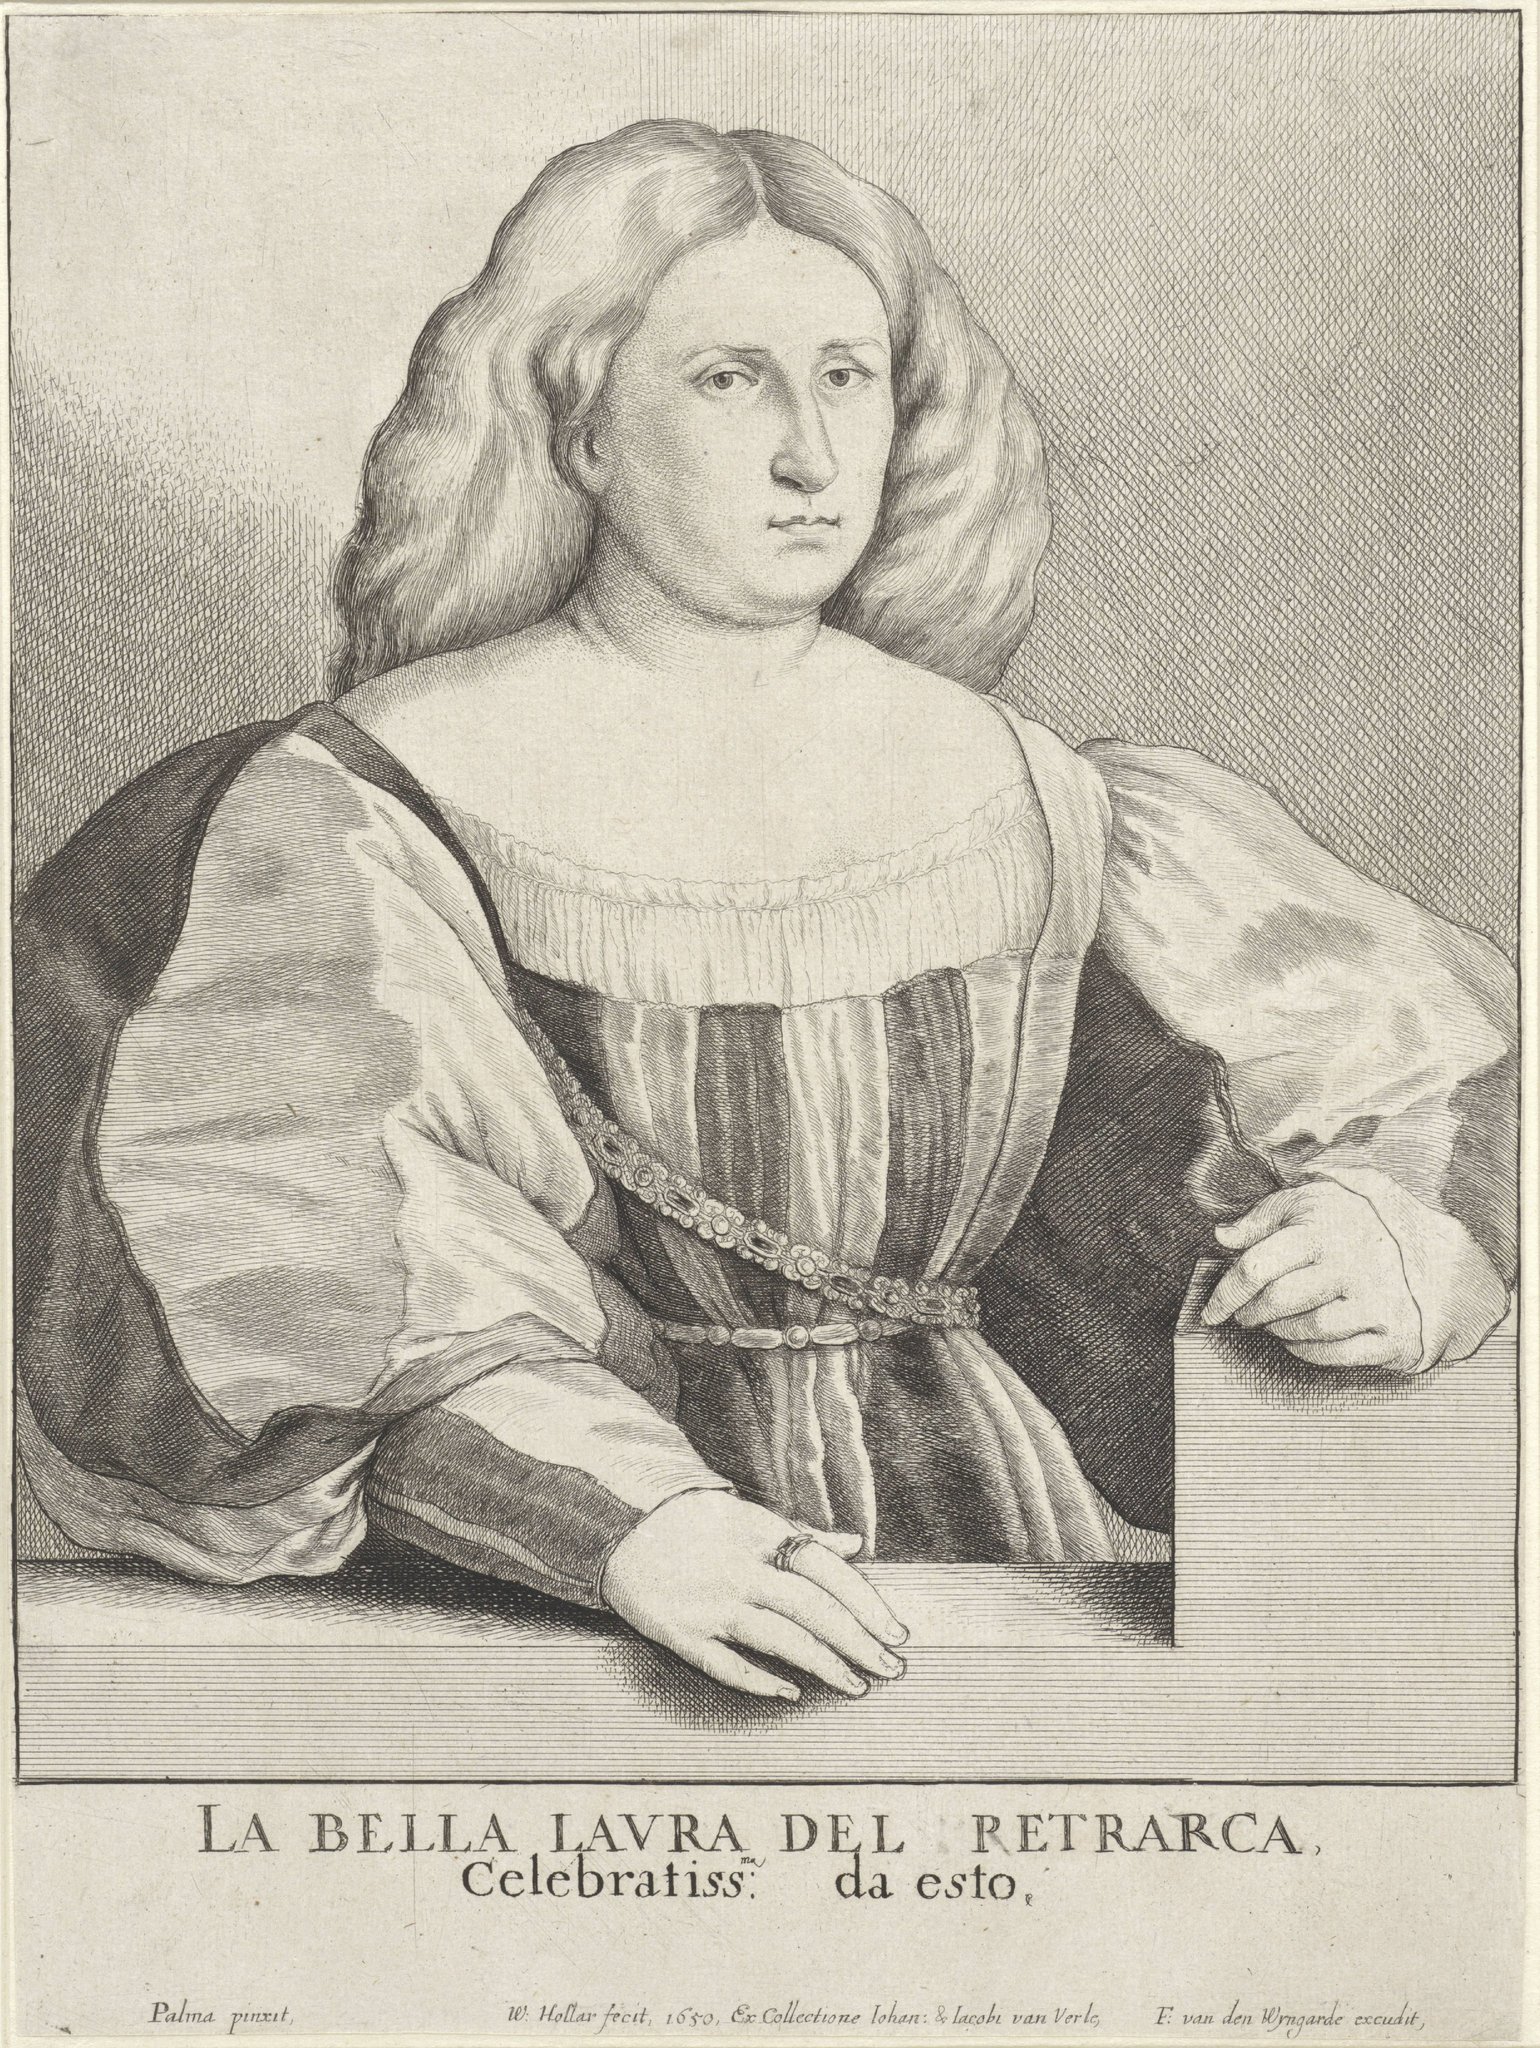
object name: print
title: Portret van Catharina Cornaro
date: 1649-1651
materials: paper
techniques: etching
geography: antwerp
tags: francesco petrarca, venice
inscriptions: collector's mark: Lugt 906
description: De prent maakt deel uit van een tiendelige serie met Italiaanse portretten (ongenummerd).